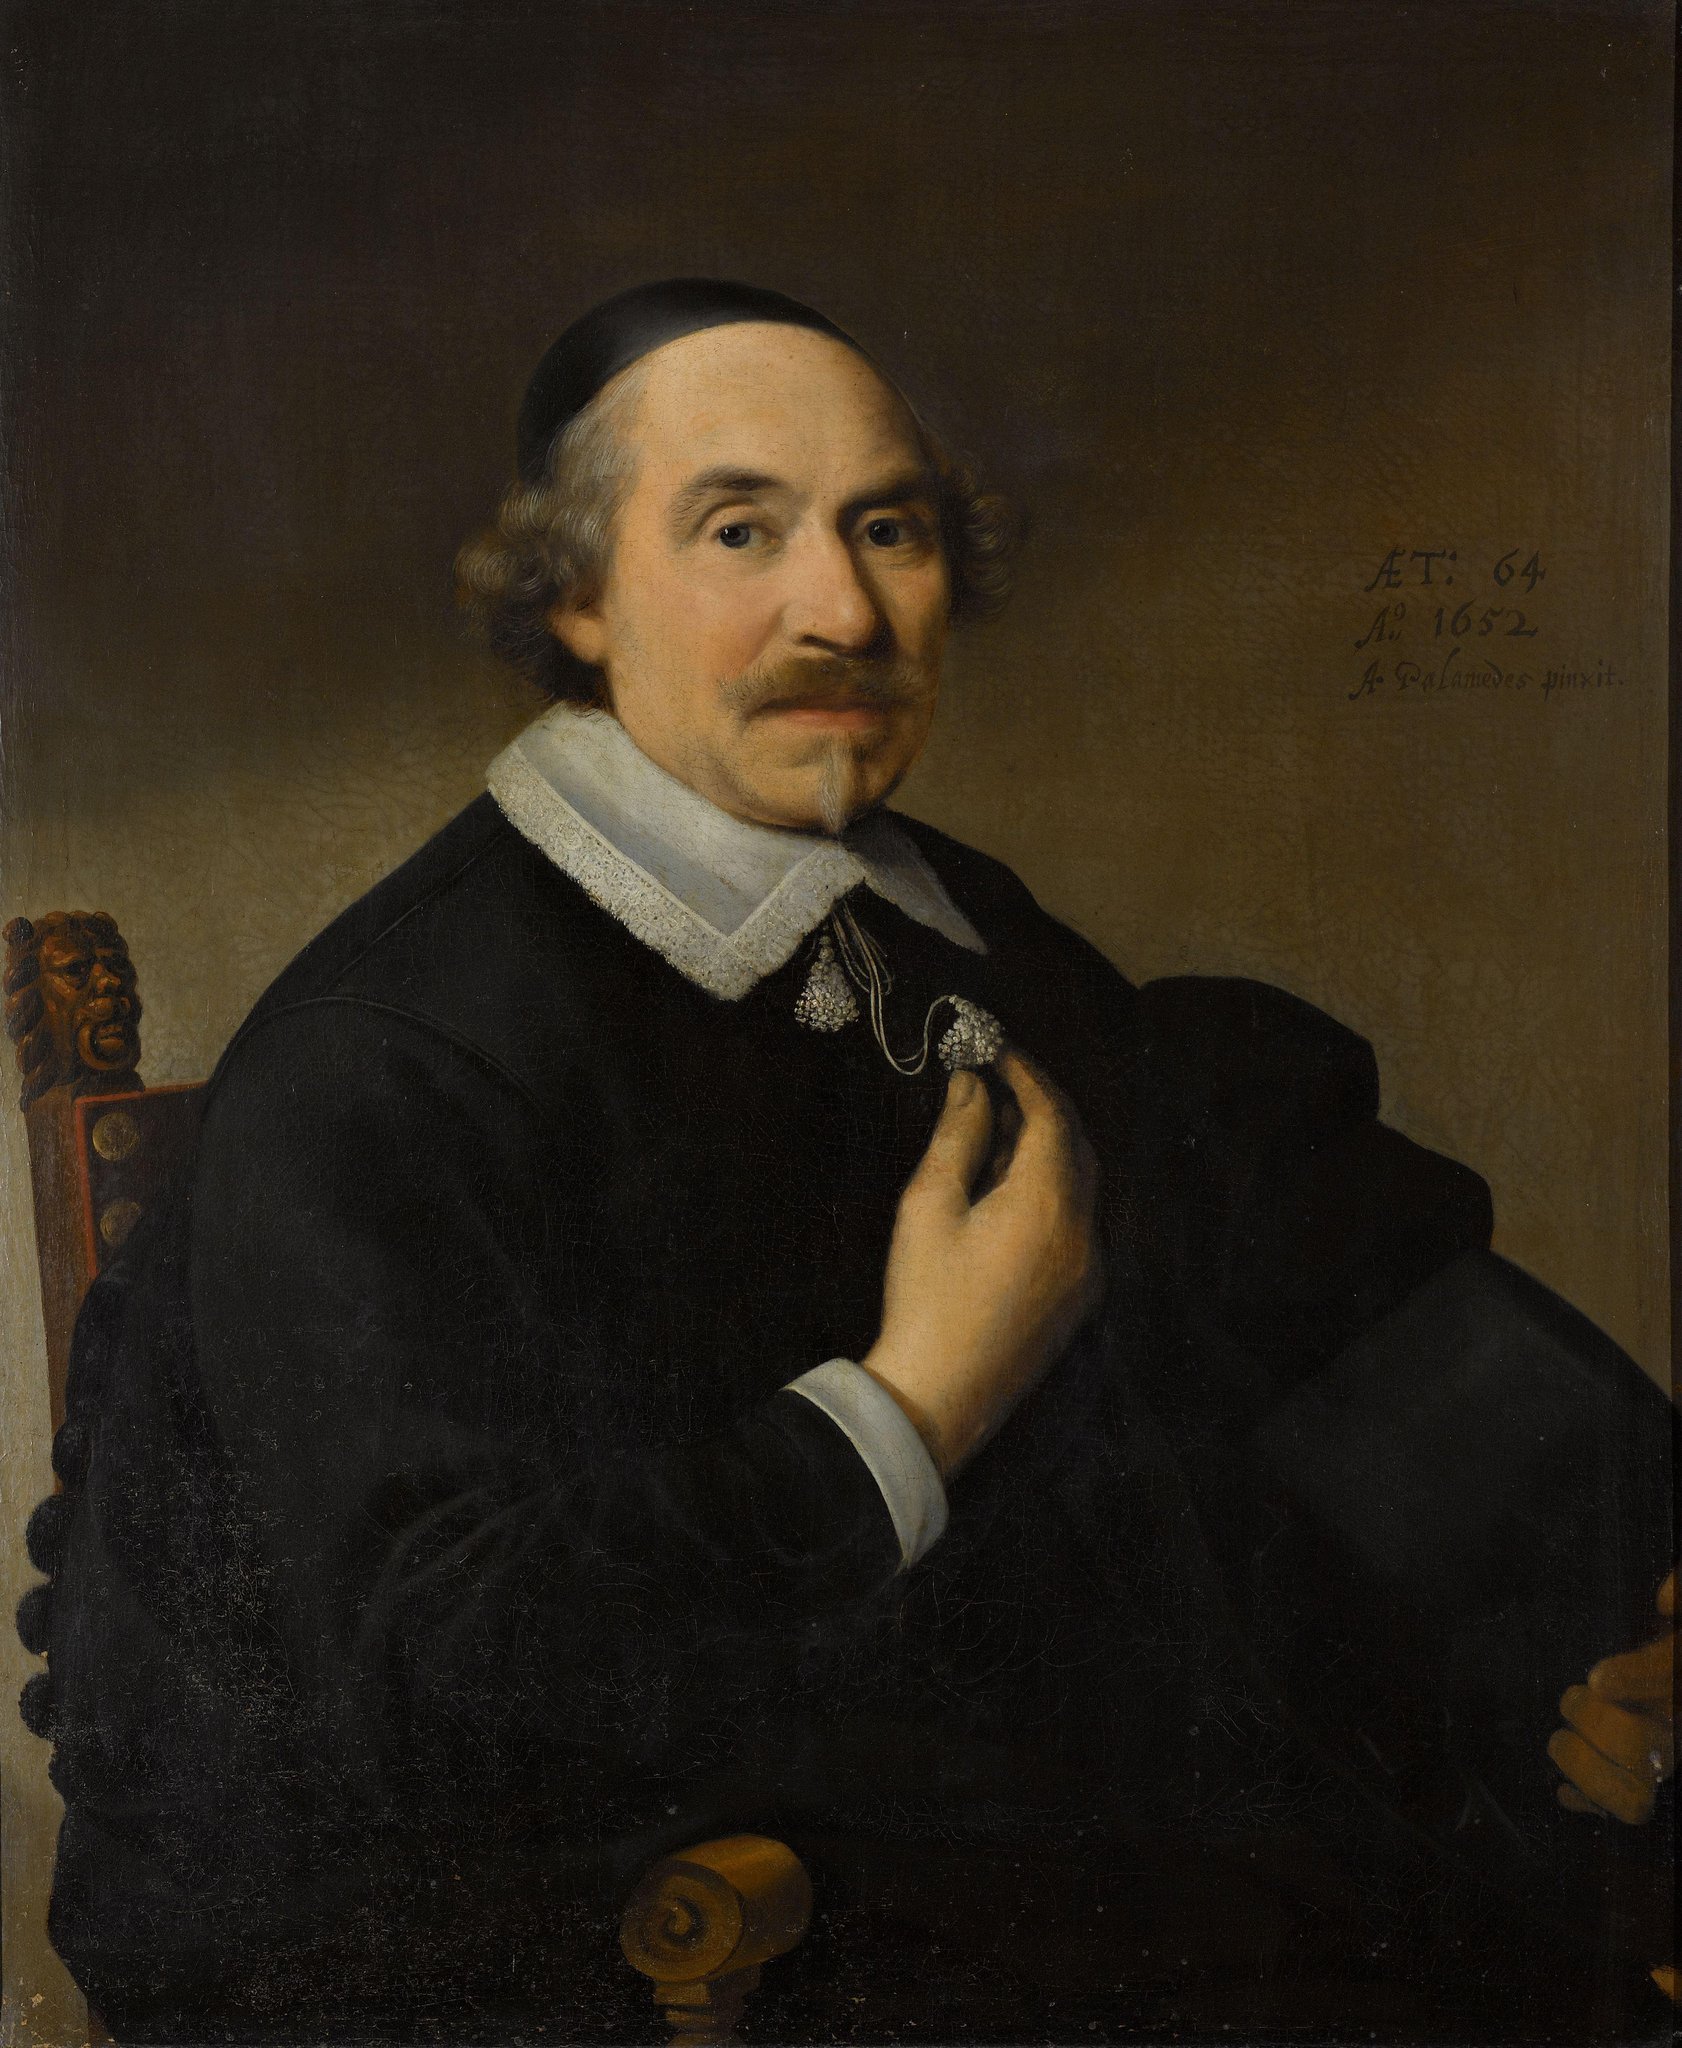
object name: painting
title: Portrait of Pieter de Witte (1588-1653). Burgomaster of Zierikzee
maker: anthonie palamedesz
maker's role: draughtsman, painter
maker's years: 1601-1673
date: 1652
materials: canvas, oil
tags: painter, historical persons, portrait, self-portrait of painter, portrait, self-portrait of artist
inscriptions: inscription, centre right: ‘ÆT: 64’, signature and date, centre right: ‘A.º 1652 / A. Palamedes pinxit.’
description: Portret van een man, waarschijnlijk Pieter Anthonisz van Bronckhorst (1588-1661). Ten halven lijve, zittende in een stoel, met de rechterhand pakt hij een kwastje van zijn kraag vast. Pendant van SK-A-1616.